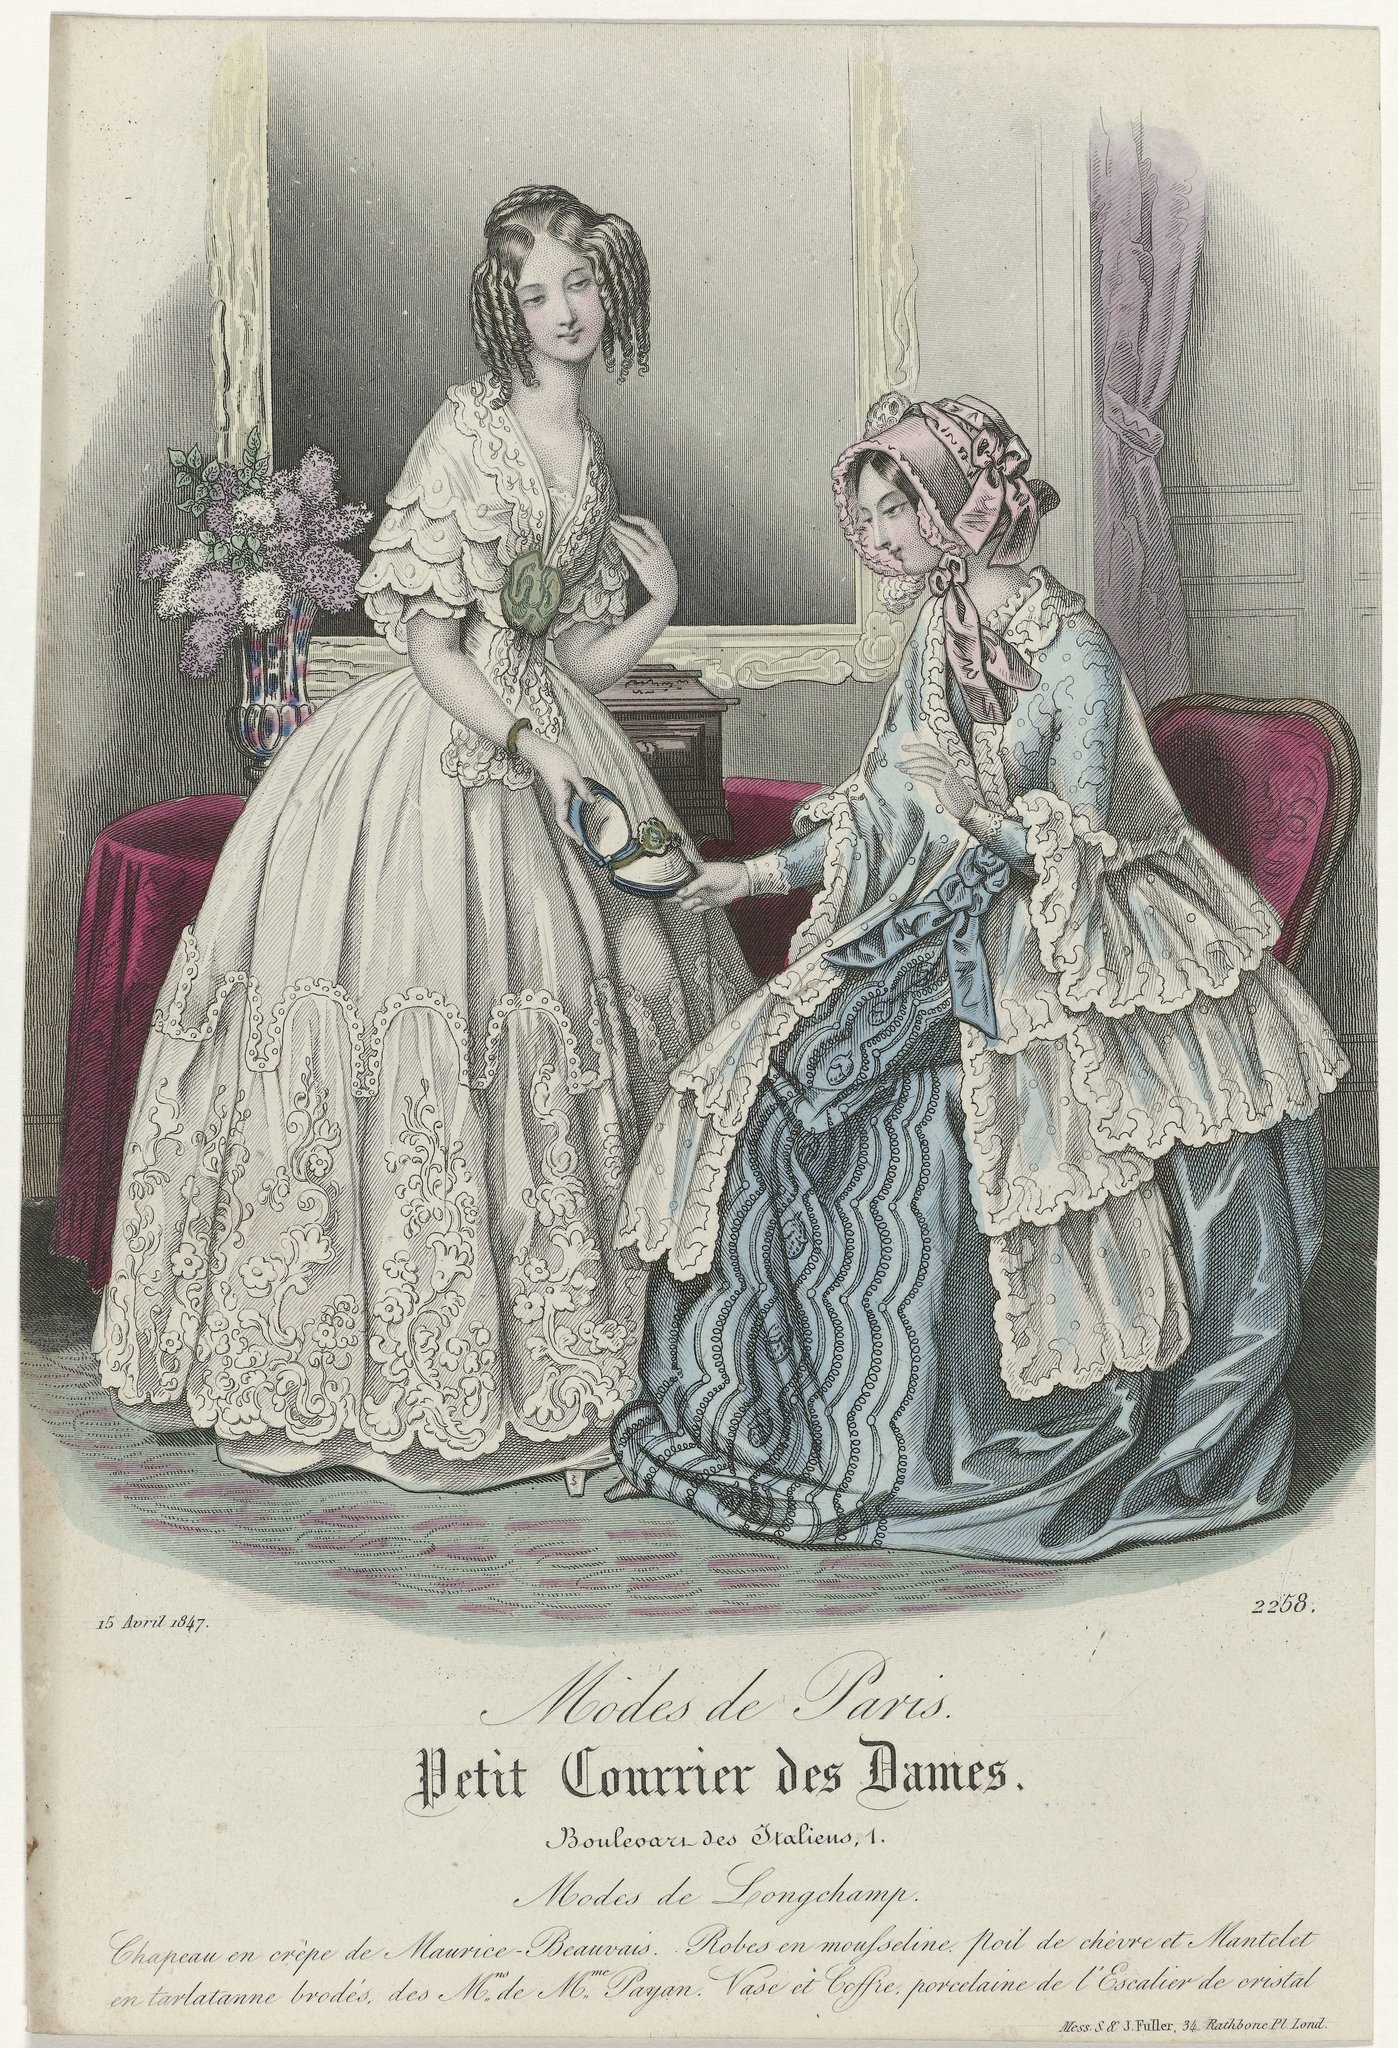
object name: fashion print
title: Petit Courrier des Dames, 15 avril 1847, No. 2258 : Chapeau en crépe de Maurice-Beauvais (...)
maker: Anonymous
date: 1847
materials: paper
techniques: engraving, hand coloring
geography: london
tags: clothing for the upper part of the body (mantelet) (+ women's clothes), fashion plates, head-gear: hat (+ women's clothes), dress, gown (+ women's clothes), flowers in a vase, bracelet, wristlet (+ women's clothes), display of jewels, etc.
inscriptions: title: ‘Modes de Paris. / Petit Courrier des Dames.’, caption: ‘Modes de Longchamp. / Chapeau en crèpe de Maurice-Beauvais. Robes en mousseline. Poil de chèvre et Mantelet en tarlatanne brodés, des M"ns de M"me Payan. Vase et Coffre. porcelaine de l'Escalier de cristal’, address: ‘Boulevart des Italiens, 1. / Mess. S. & J. Fuller, 34 Rathbone Pl. Lond.’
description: Twee vrouwen in een interieur, van wie er één een sieraad in een geopend doosje toont. Volgens het onderschrift: 'modes de Longchamp.' Japonnen van mousseline. Hoed van crêpe van Maurice-Beauvais. 'Poil de chèvre' en kleine schoudermantel van geborduurde 'tarlatan' (open katoenen weefsel), uit de winkels van Payan. Op de tafel een vaas en kist van 'porcelaine de l'Escalier de cristal'. Prent uit het modetijdschrift Petit Courrier des Dames (1821-1868).